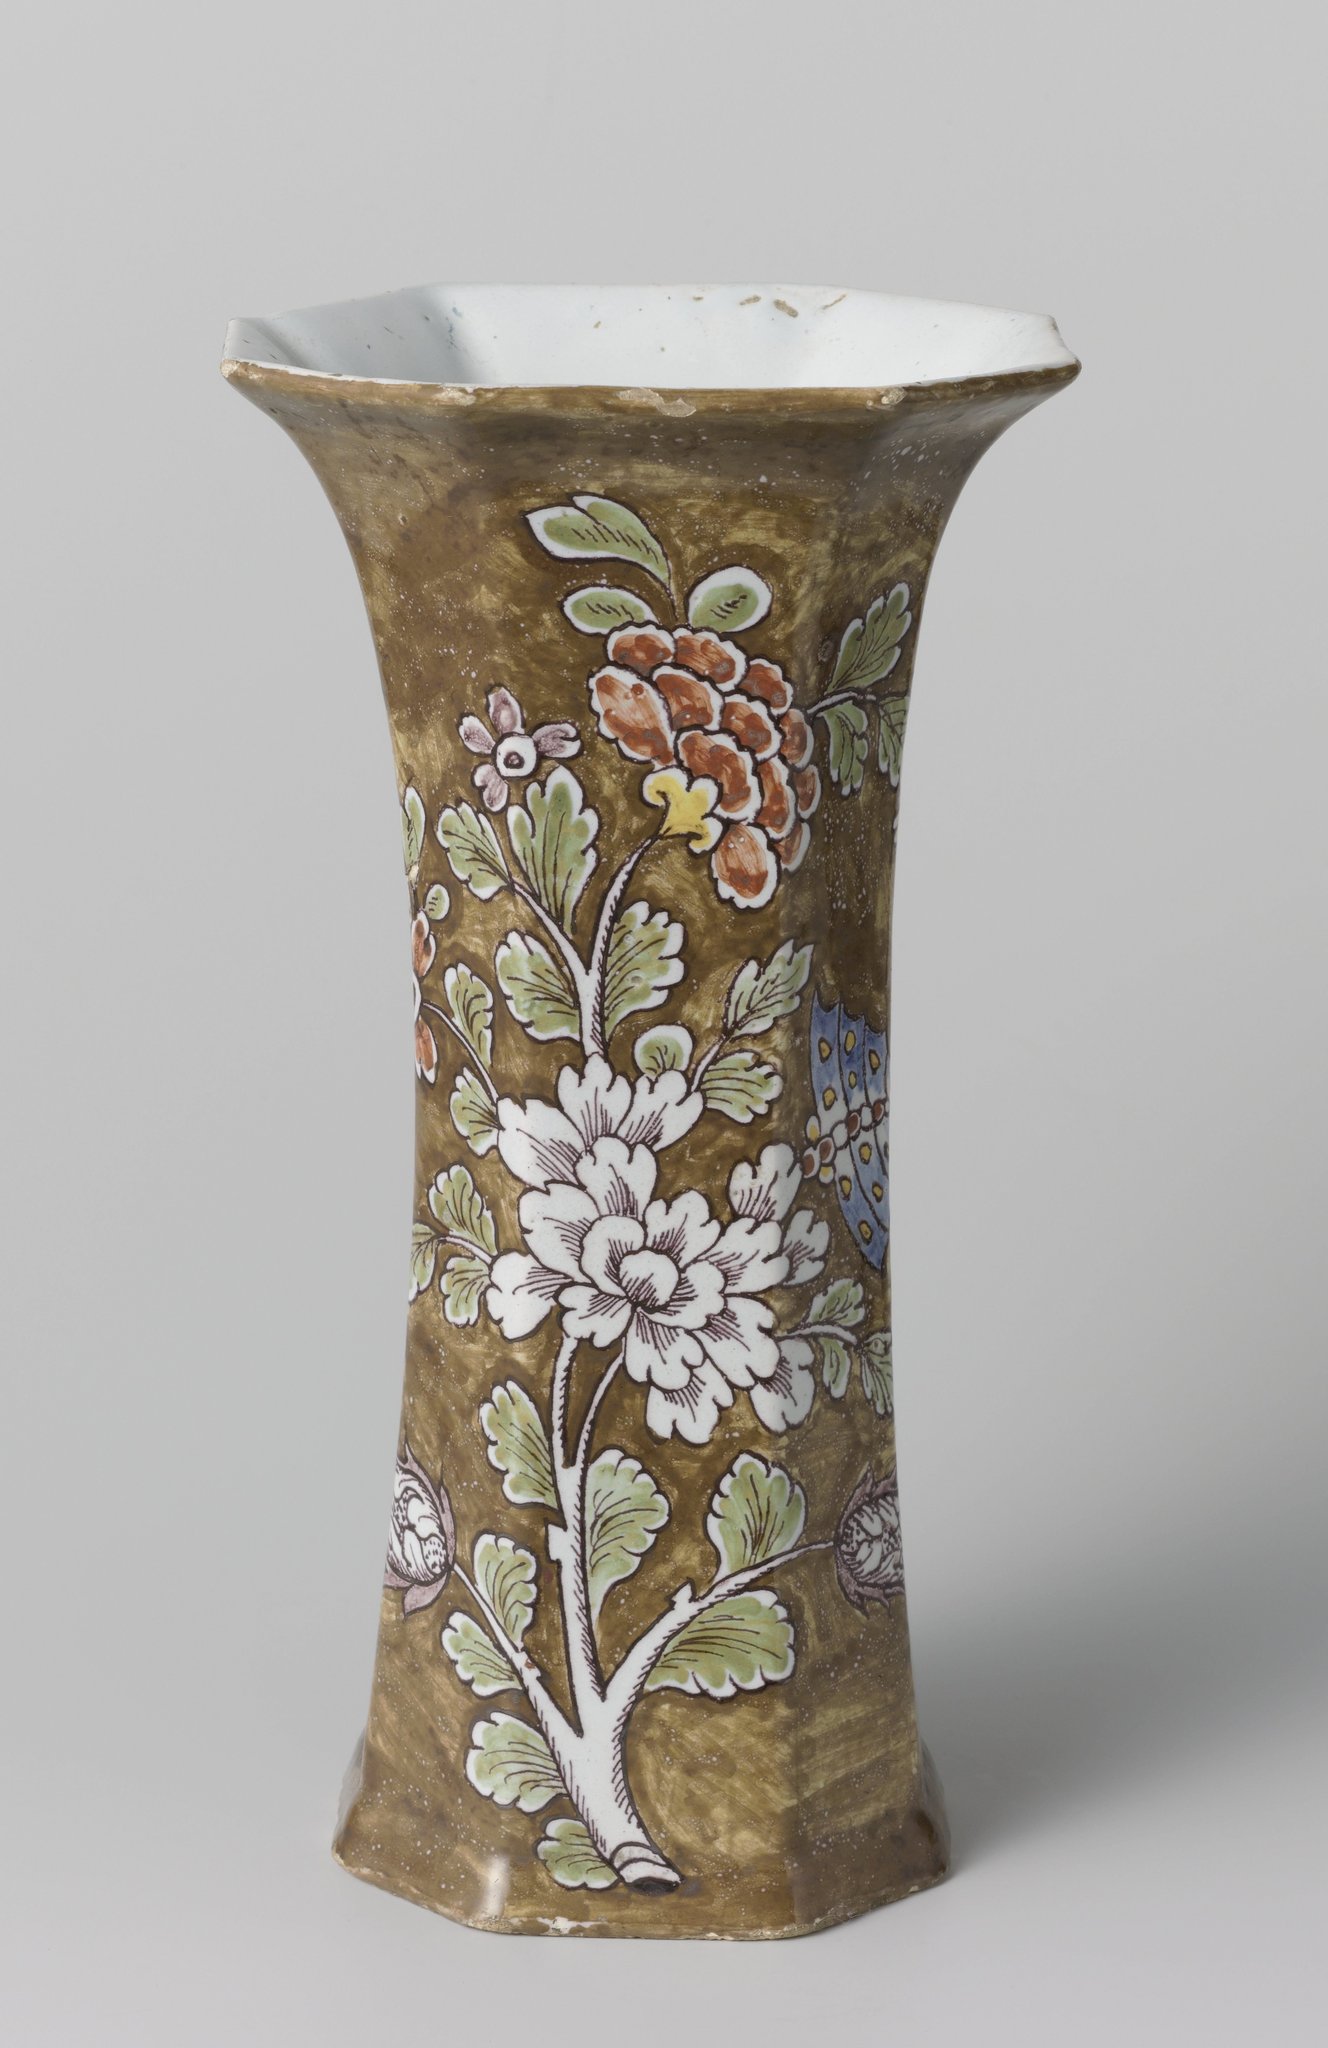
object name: kaststel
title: Vaas met op bruin fond veelkleurige beschildering van bloemtakken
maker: Anonymous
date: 1770-1800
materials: earthenware, glaze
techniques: painted, polychromy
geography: delft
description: Garniture. Delftware. Delft, c. 1780 - 1810. E. van Hoboken bequest, 1925.